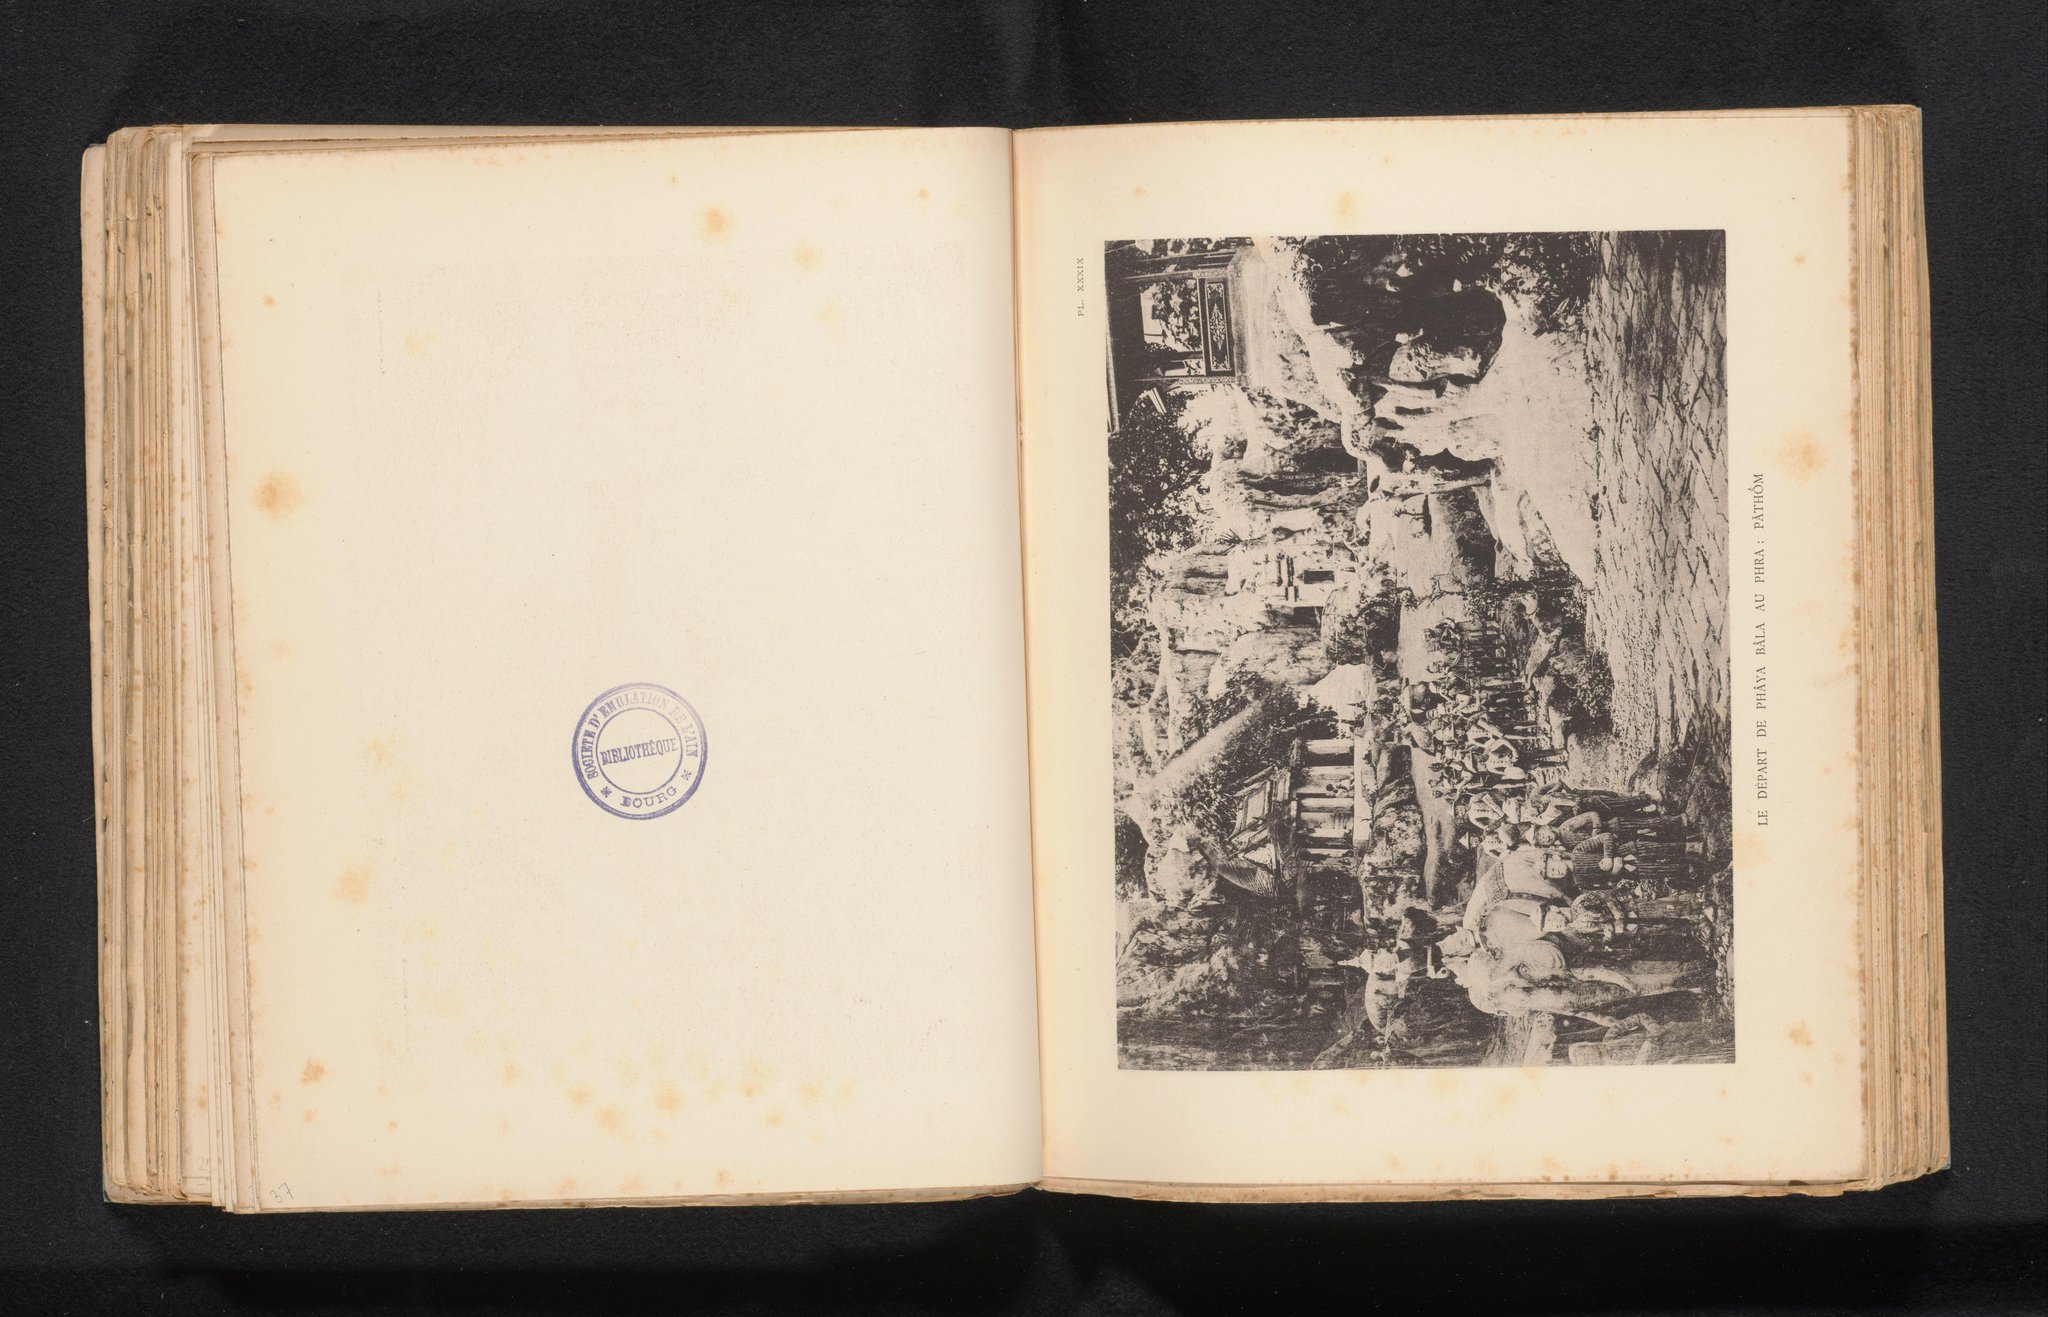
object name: page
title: Le départ de phâya bâla au phra: pătŏm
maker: Anonymous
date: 1890-1895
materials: paper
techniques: photograph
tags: statues, paintings, etc. ~ objects of worship (hinduism, buddhism, jainism)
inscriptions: collector's mark: ‘Société d'Emulation de l'Ain/ Bourg/ Bibliothèque’, inscription: ‘Pl. XXXVIX’